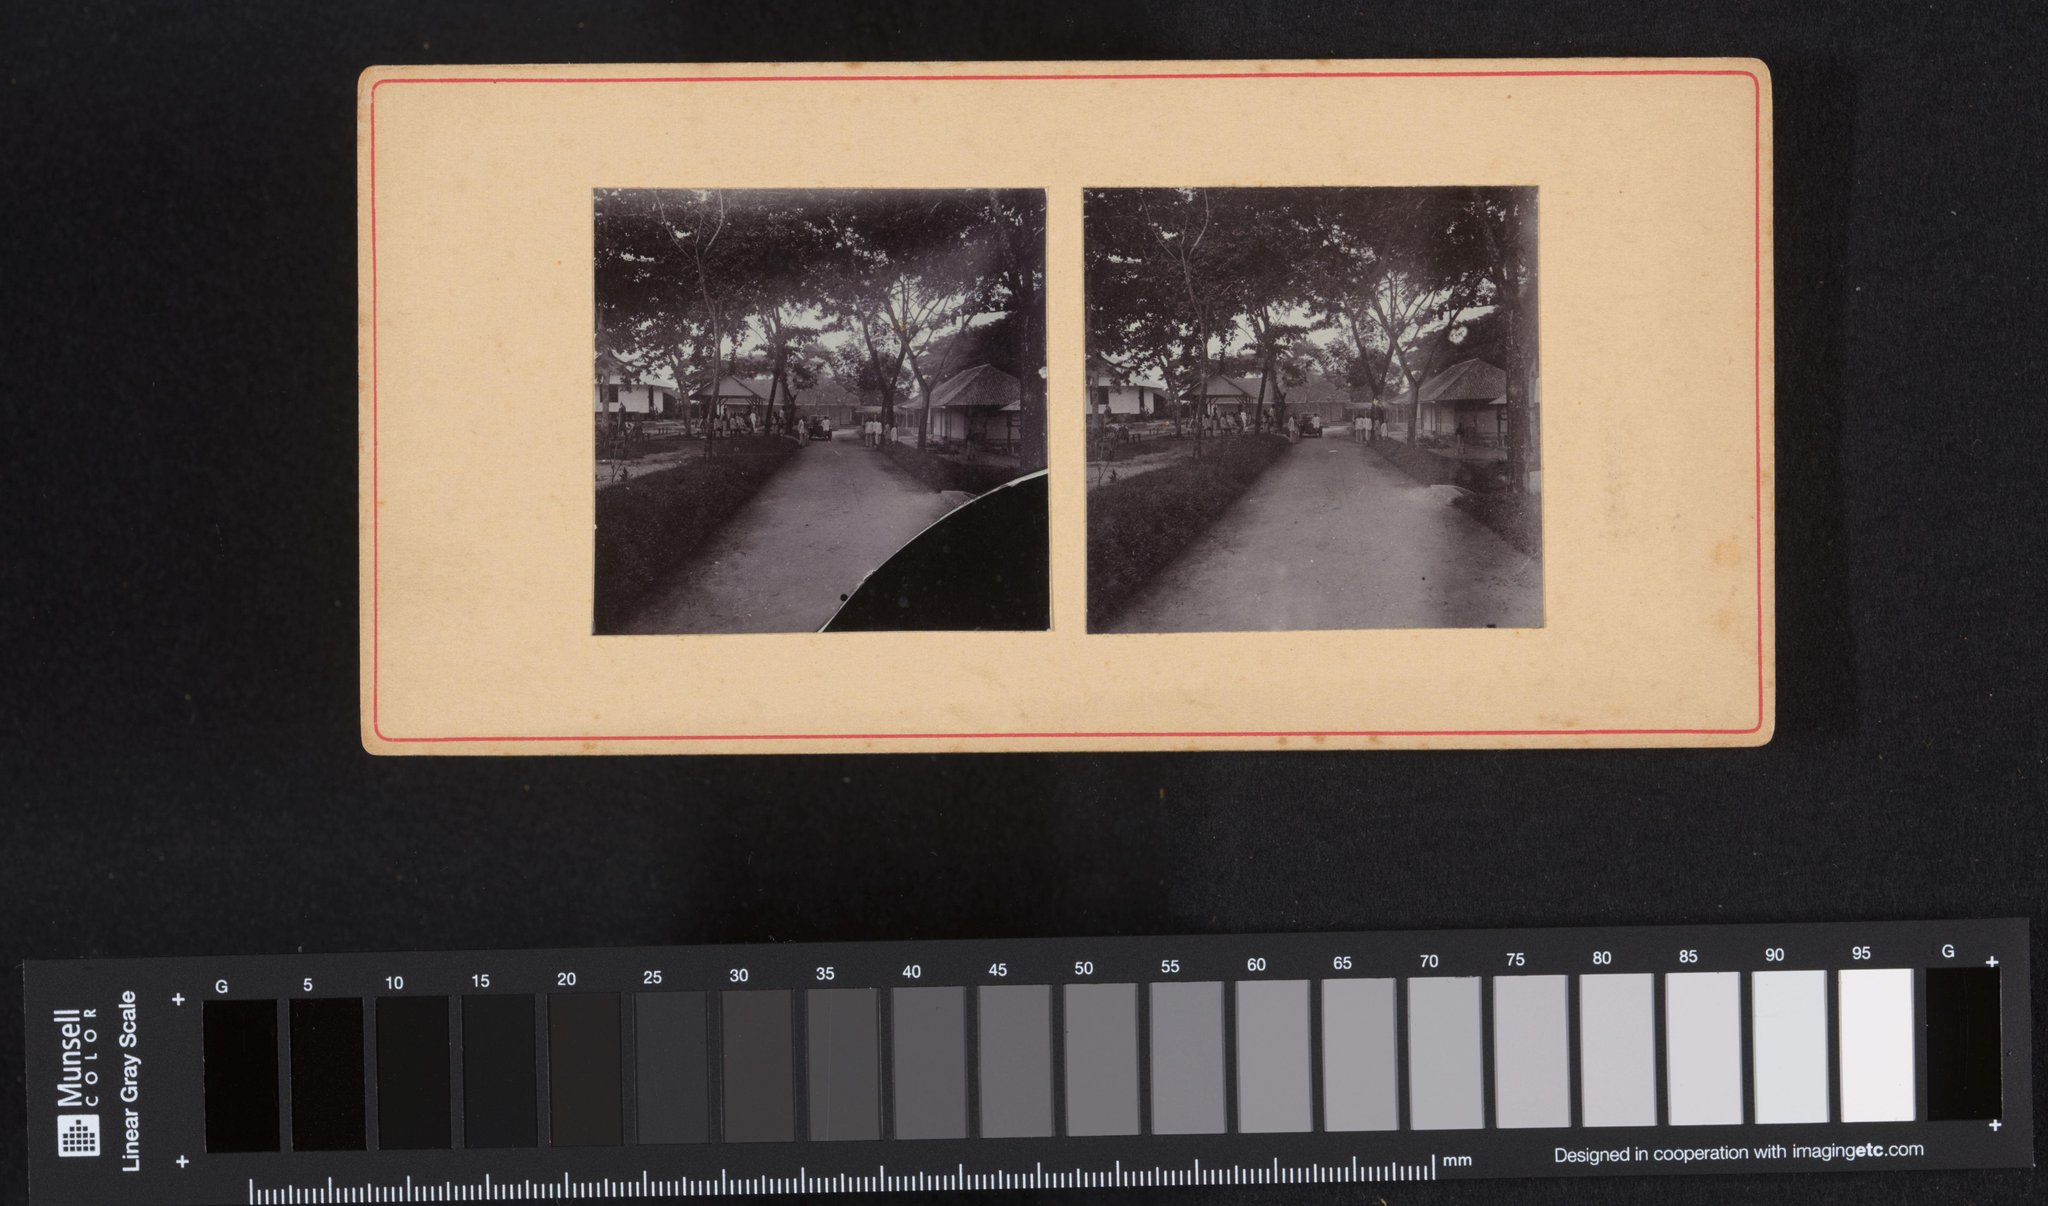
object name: stereograph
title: Huizen onder bomen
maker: robert julius boers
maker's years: 1867-1932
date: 1900-1922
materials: cardboard, photographic support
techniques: gelatin silver print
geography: bangka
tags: robert julius boers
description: Gezicht op enkele huizen onder bomen, hierbij een auto en mensen, waarschijnlijk te Banka. Onderdeel van een groep stereofoto's van Robert Julius Boers, chef van het staatsbedrijf de Banka-tinwinning op Banka, uit de periode ca. 1900-1922.